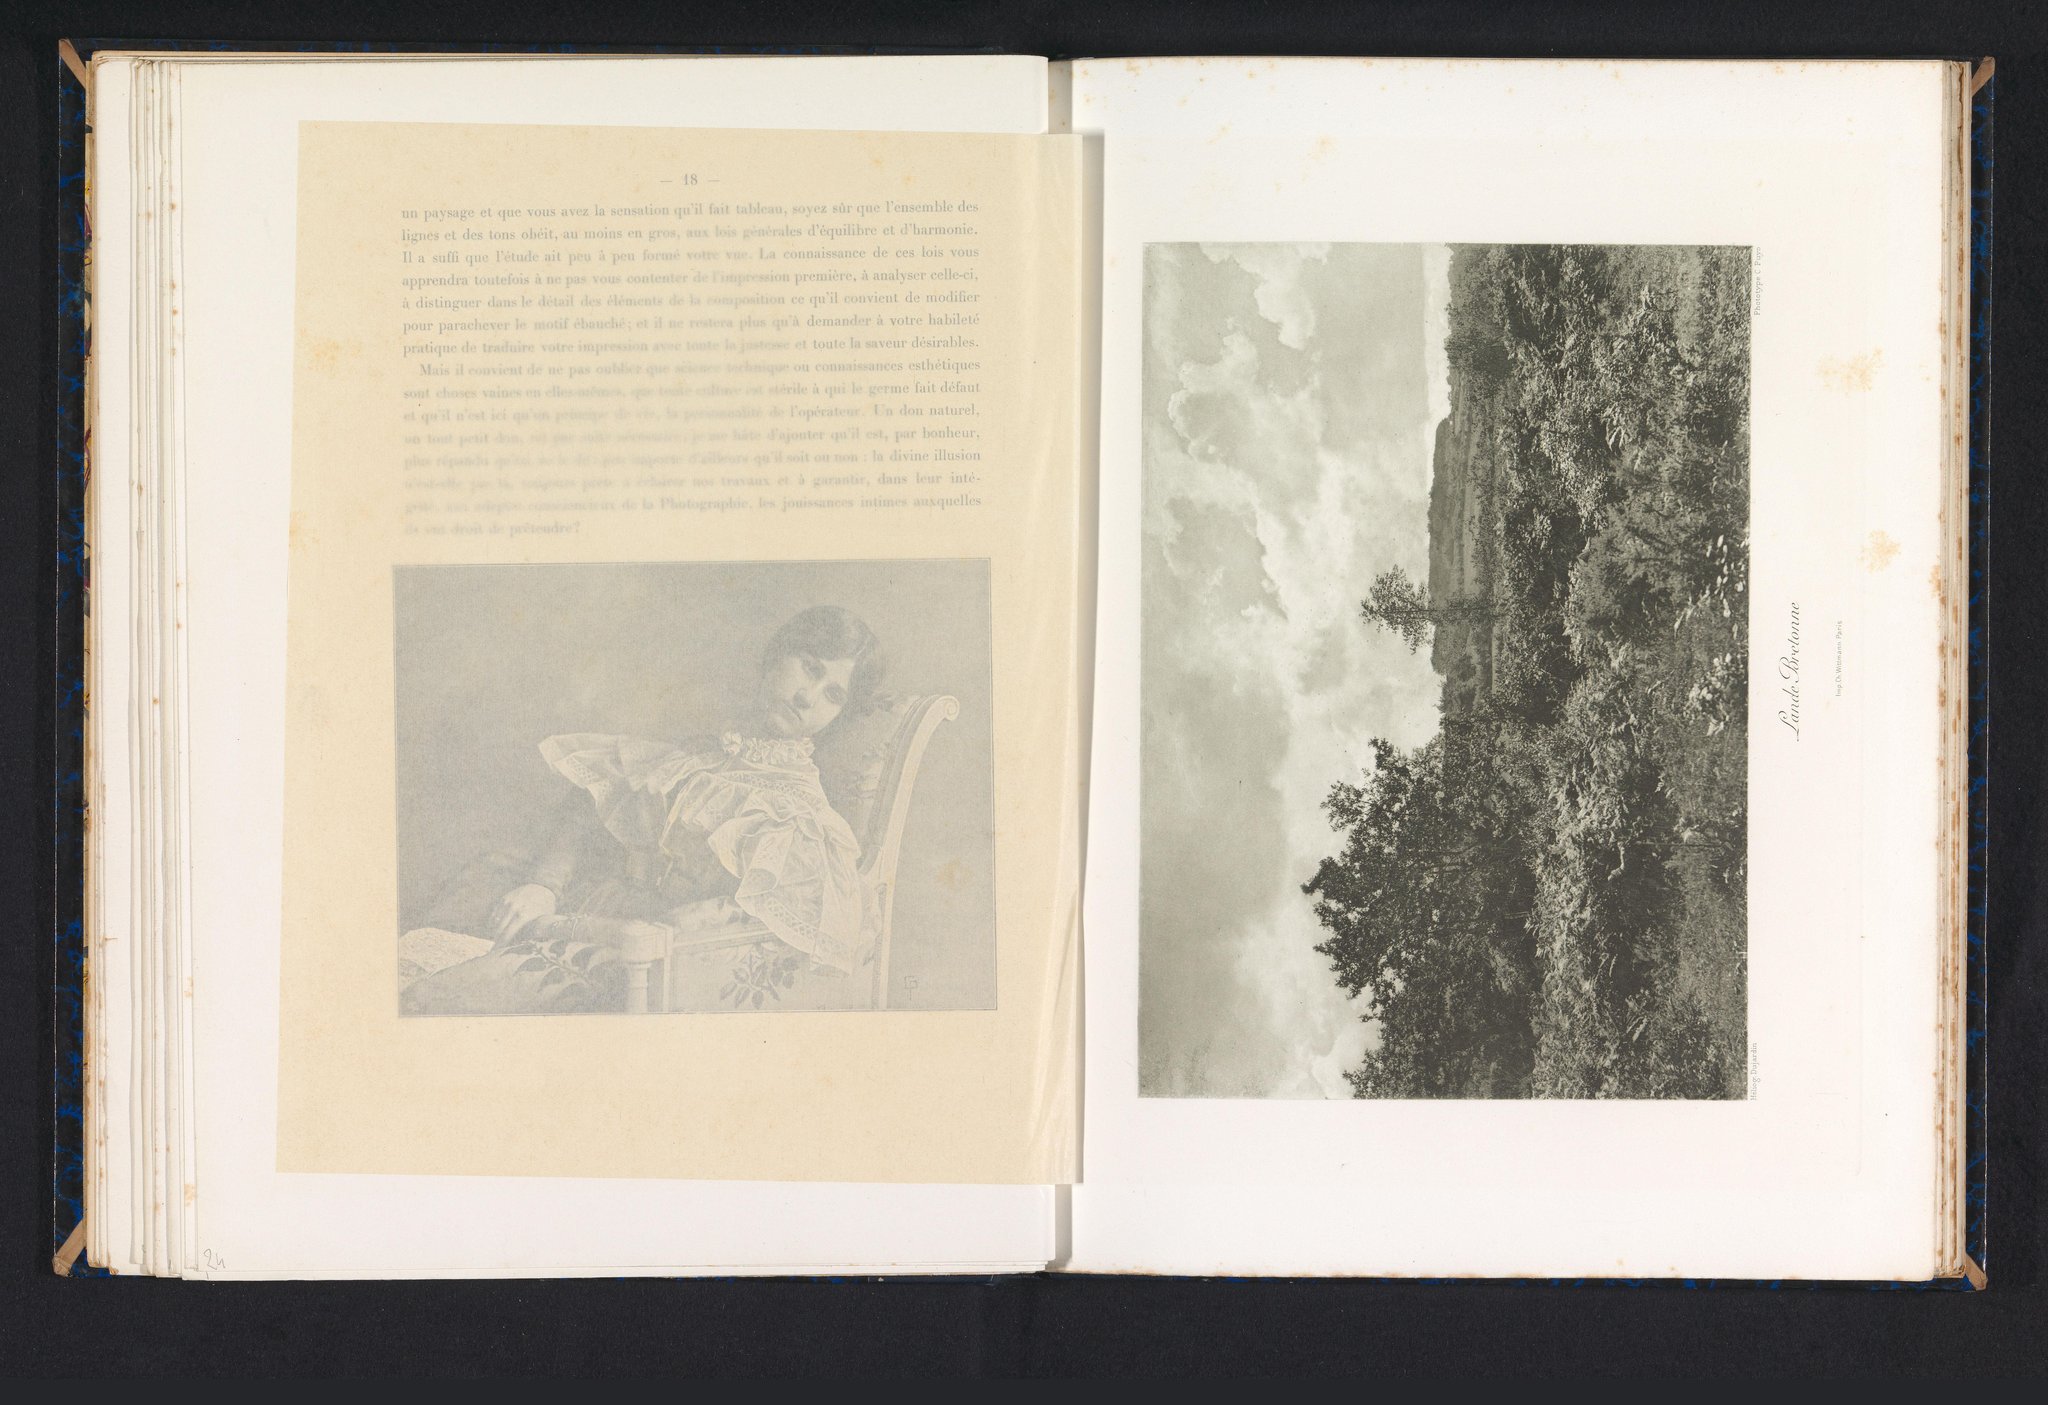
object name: page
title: Lande Bretonne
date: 1886-1896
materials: paper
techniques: photoaquatint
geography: paris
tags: forest, wood